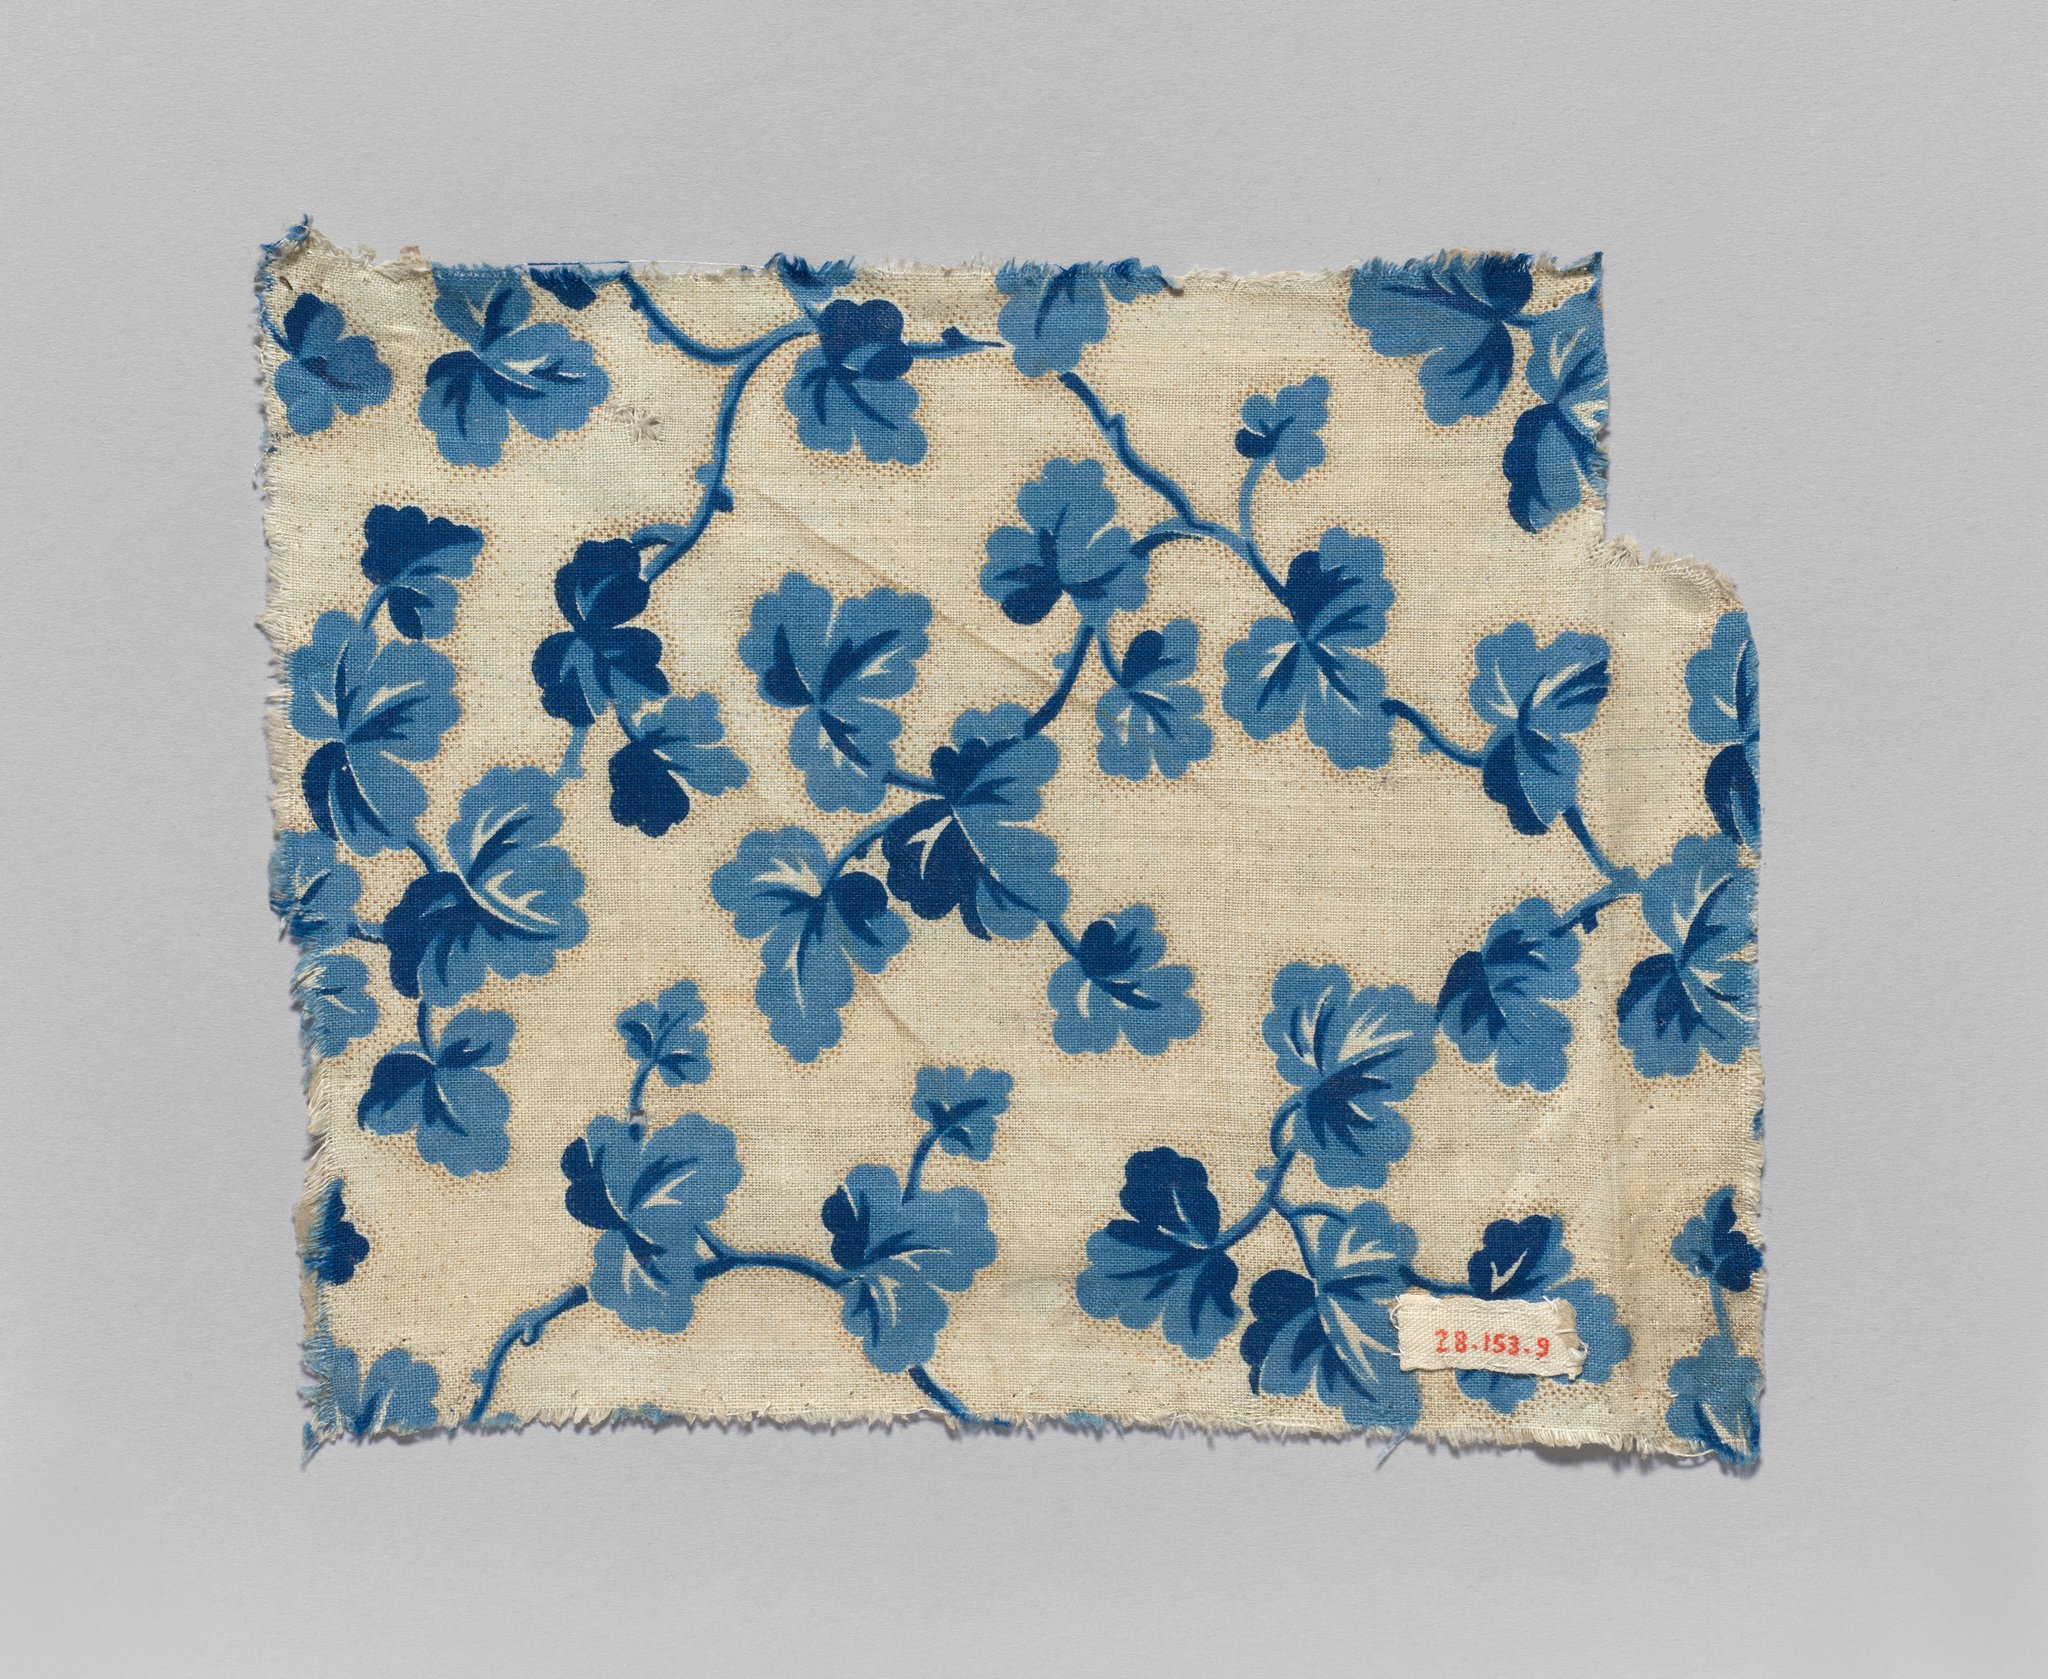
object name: piece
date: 1801-1900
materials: cotton